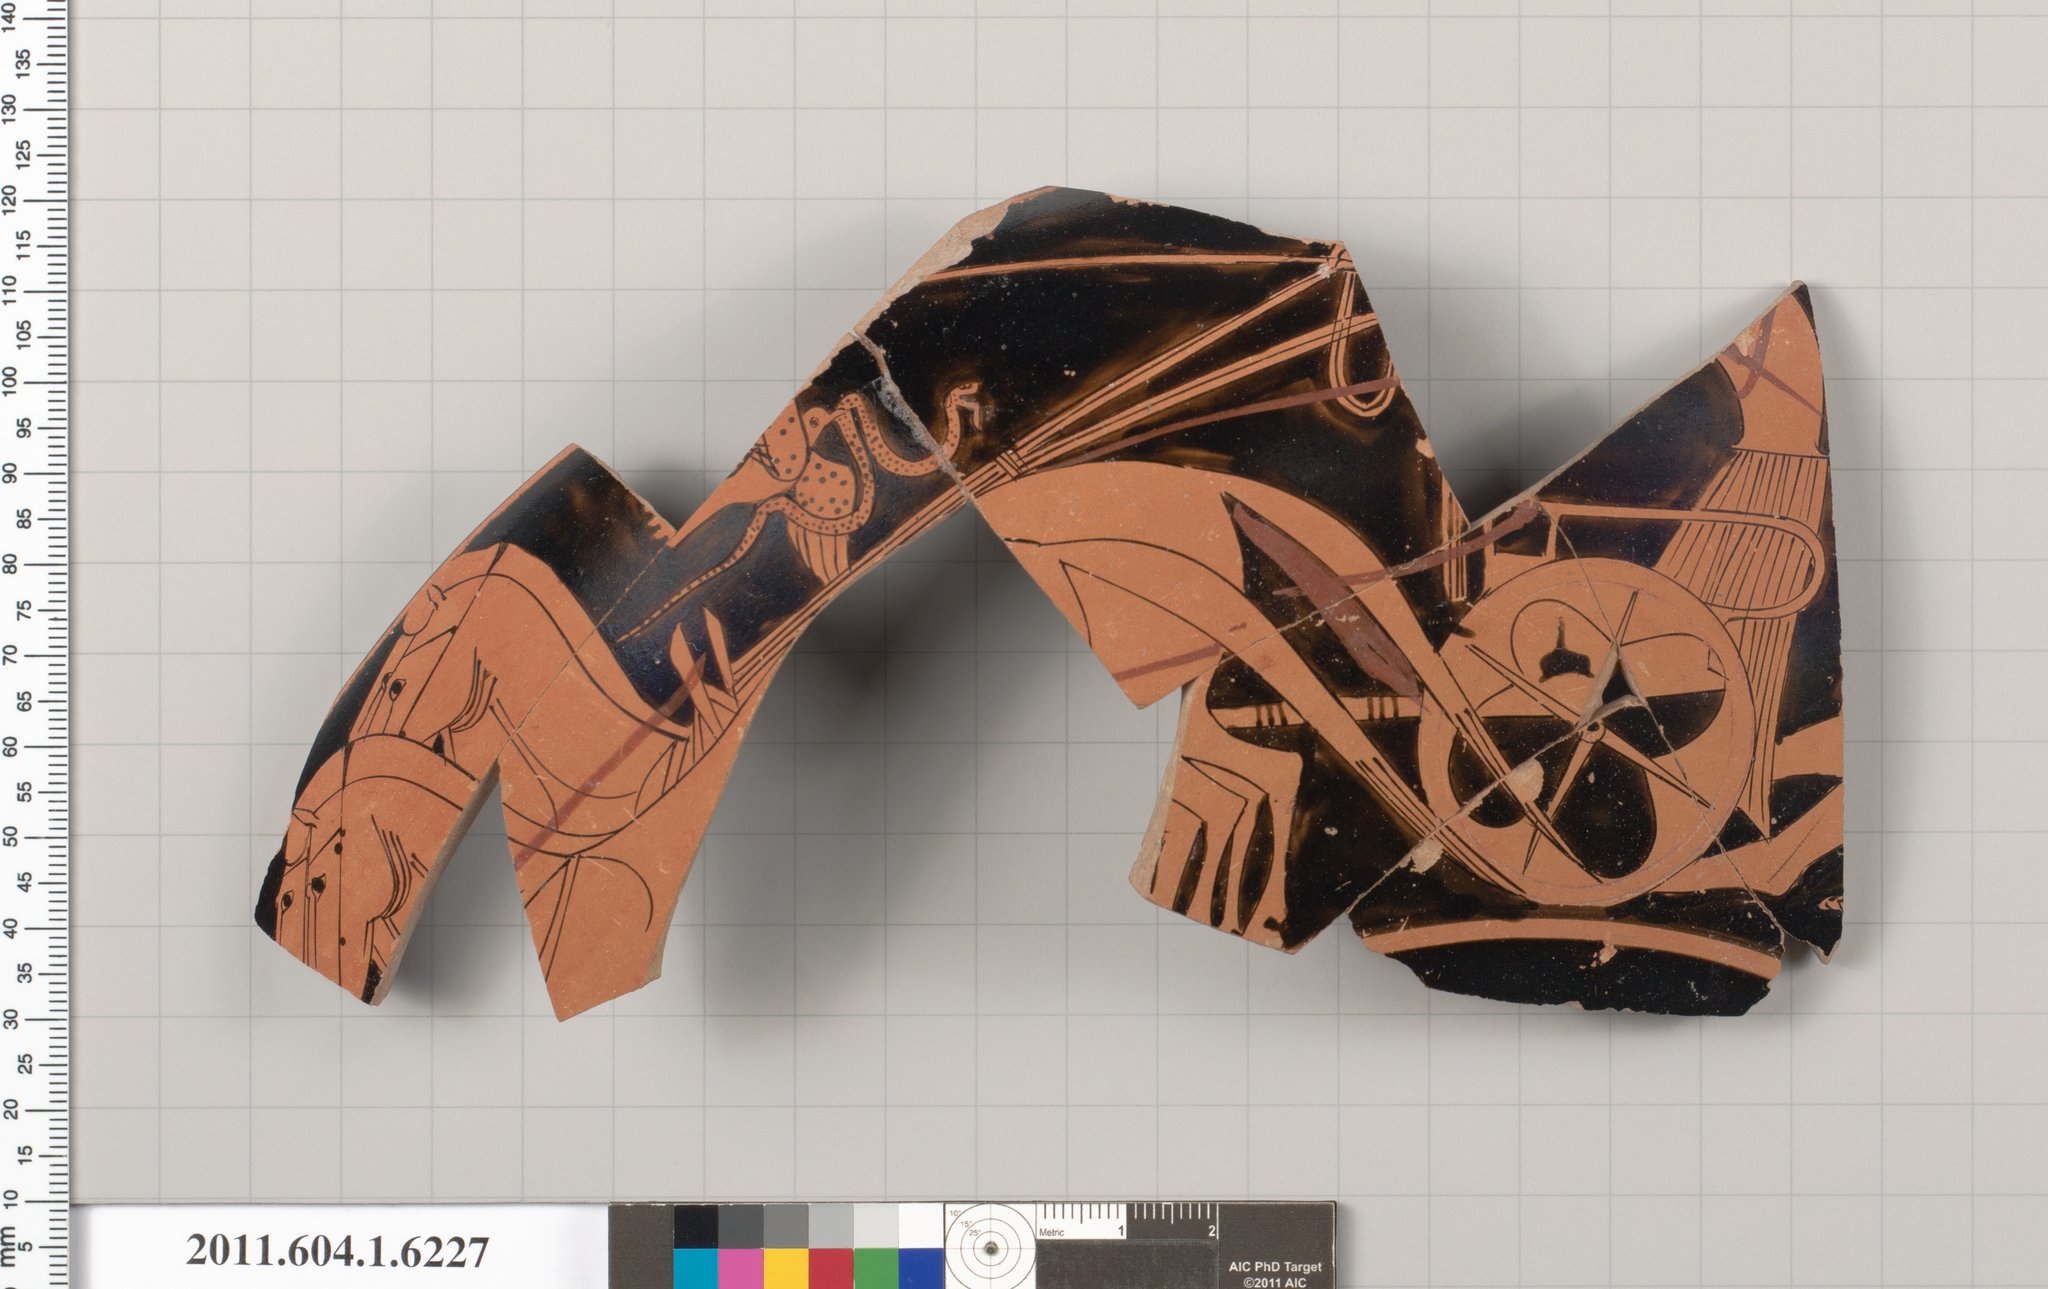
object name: kylix fragment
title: Terracotta fragment of a kylix (drinking cup)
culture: greek, attic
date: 510-500 BCE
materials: terracotta